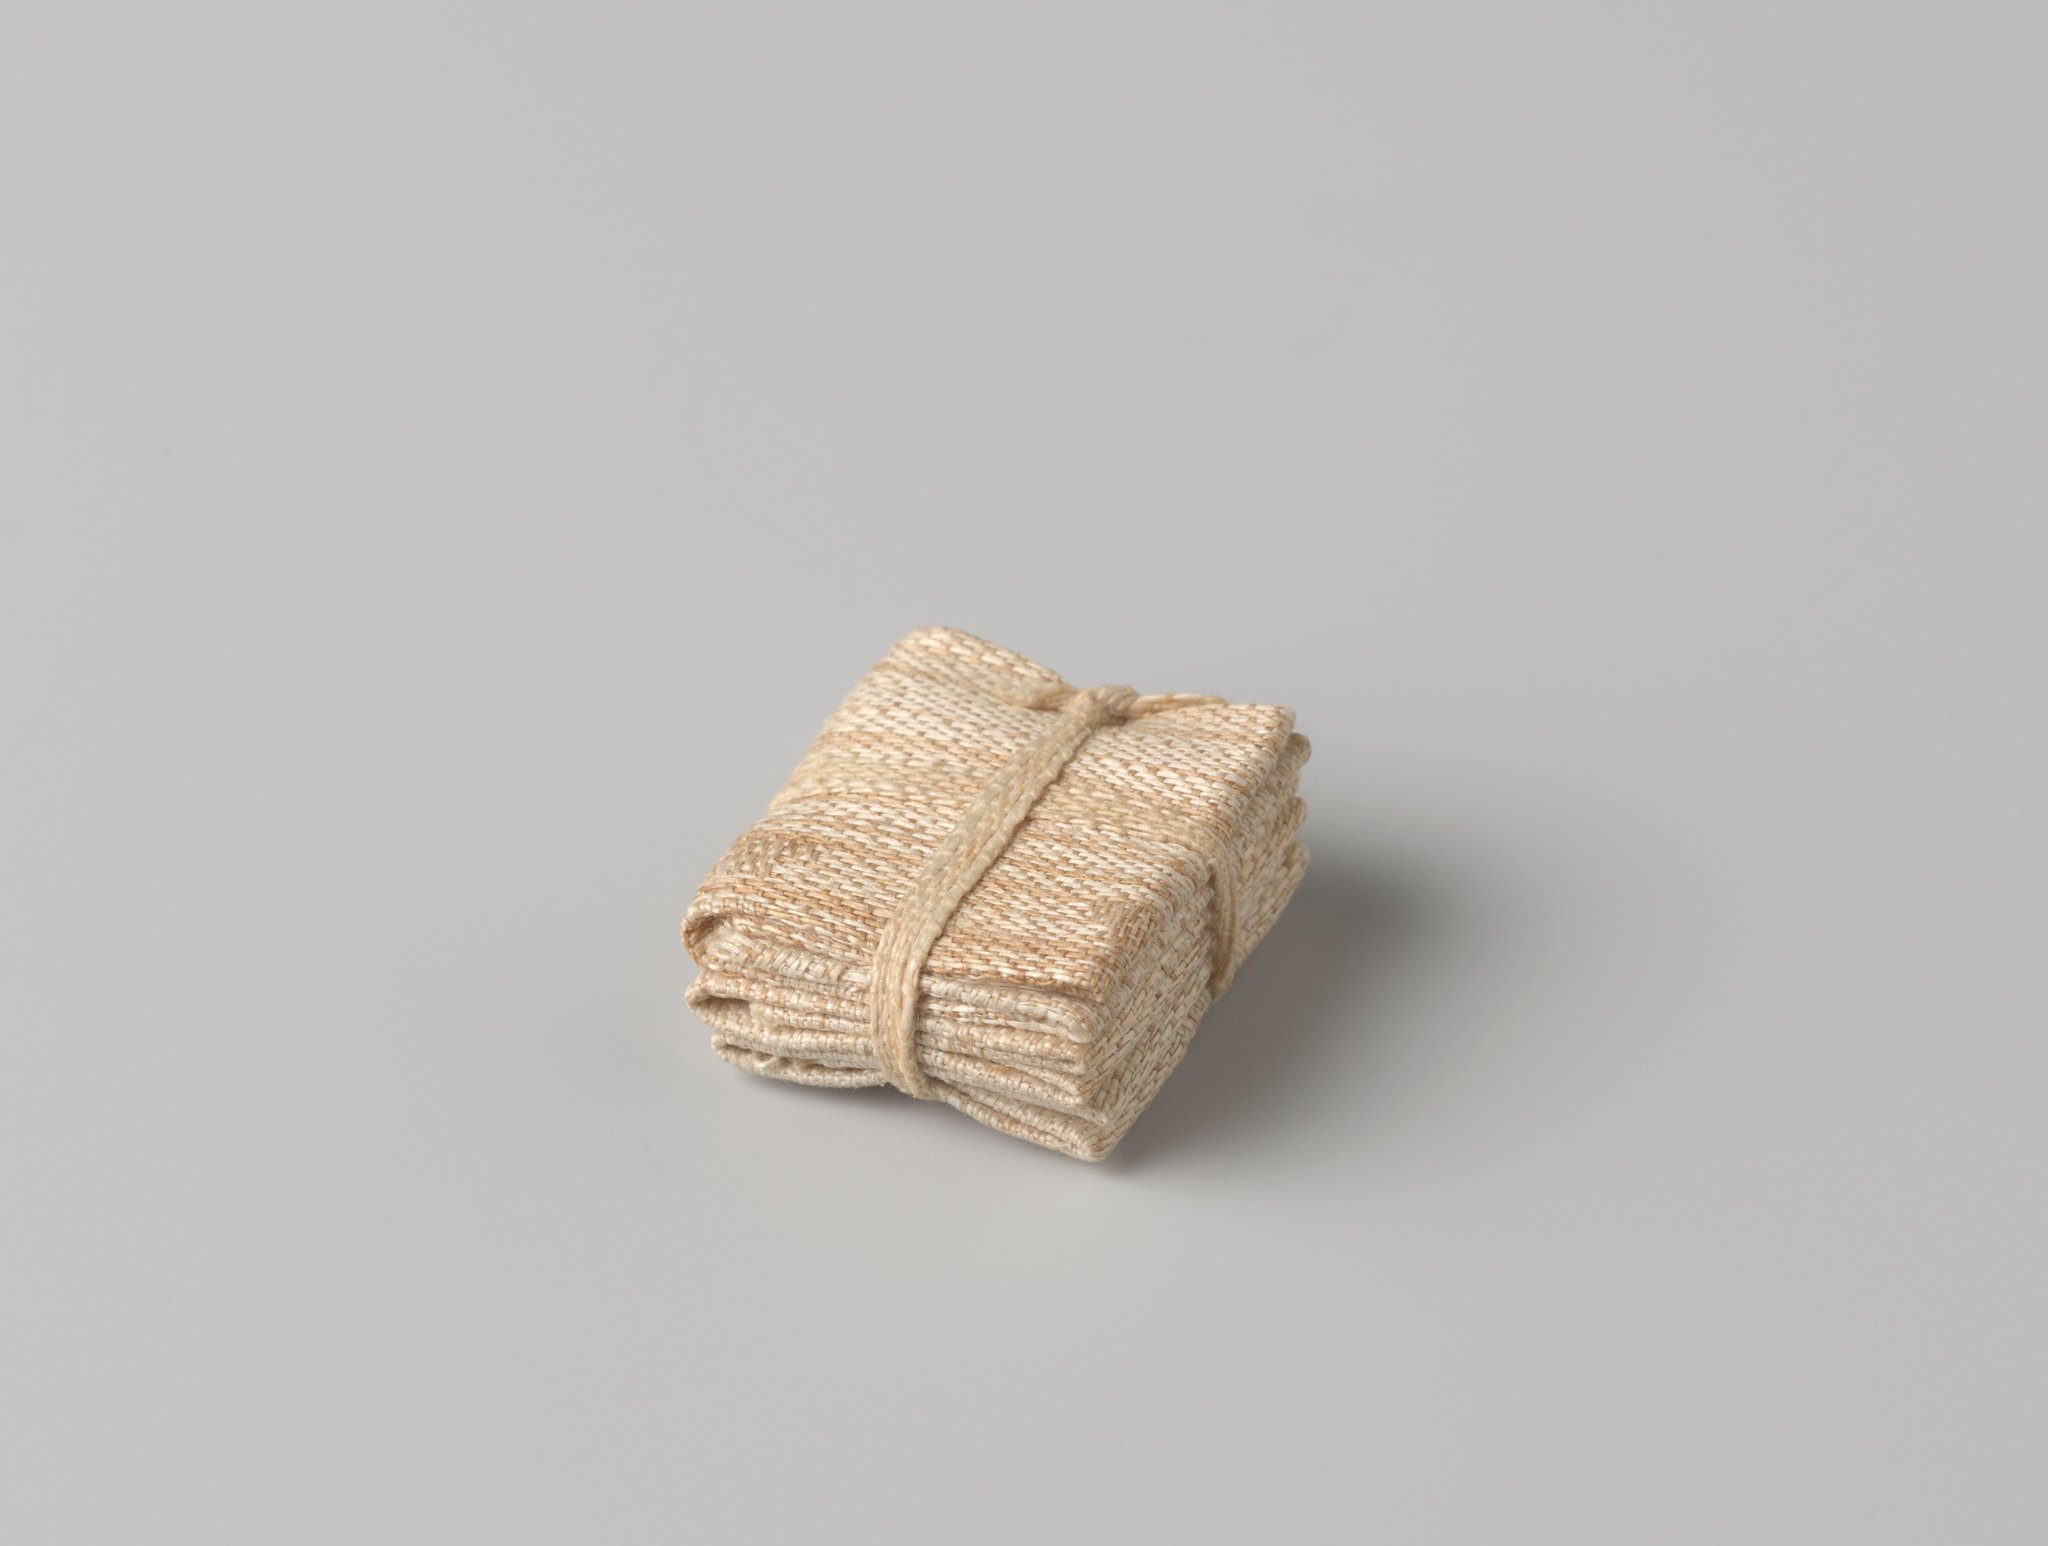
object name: miniature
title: Stapel van vier doeken, samengebonden met band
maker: Anonymous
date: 1750-1800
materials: linen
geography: netherlands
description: Een stapel van drie opgevouwen en met linnen band samengebonden doeken van linnen met damastpatroon.